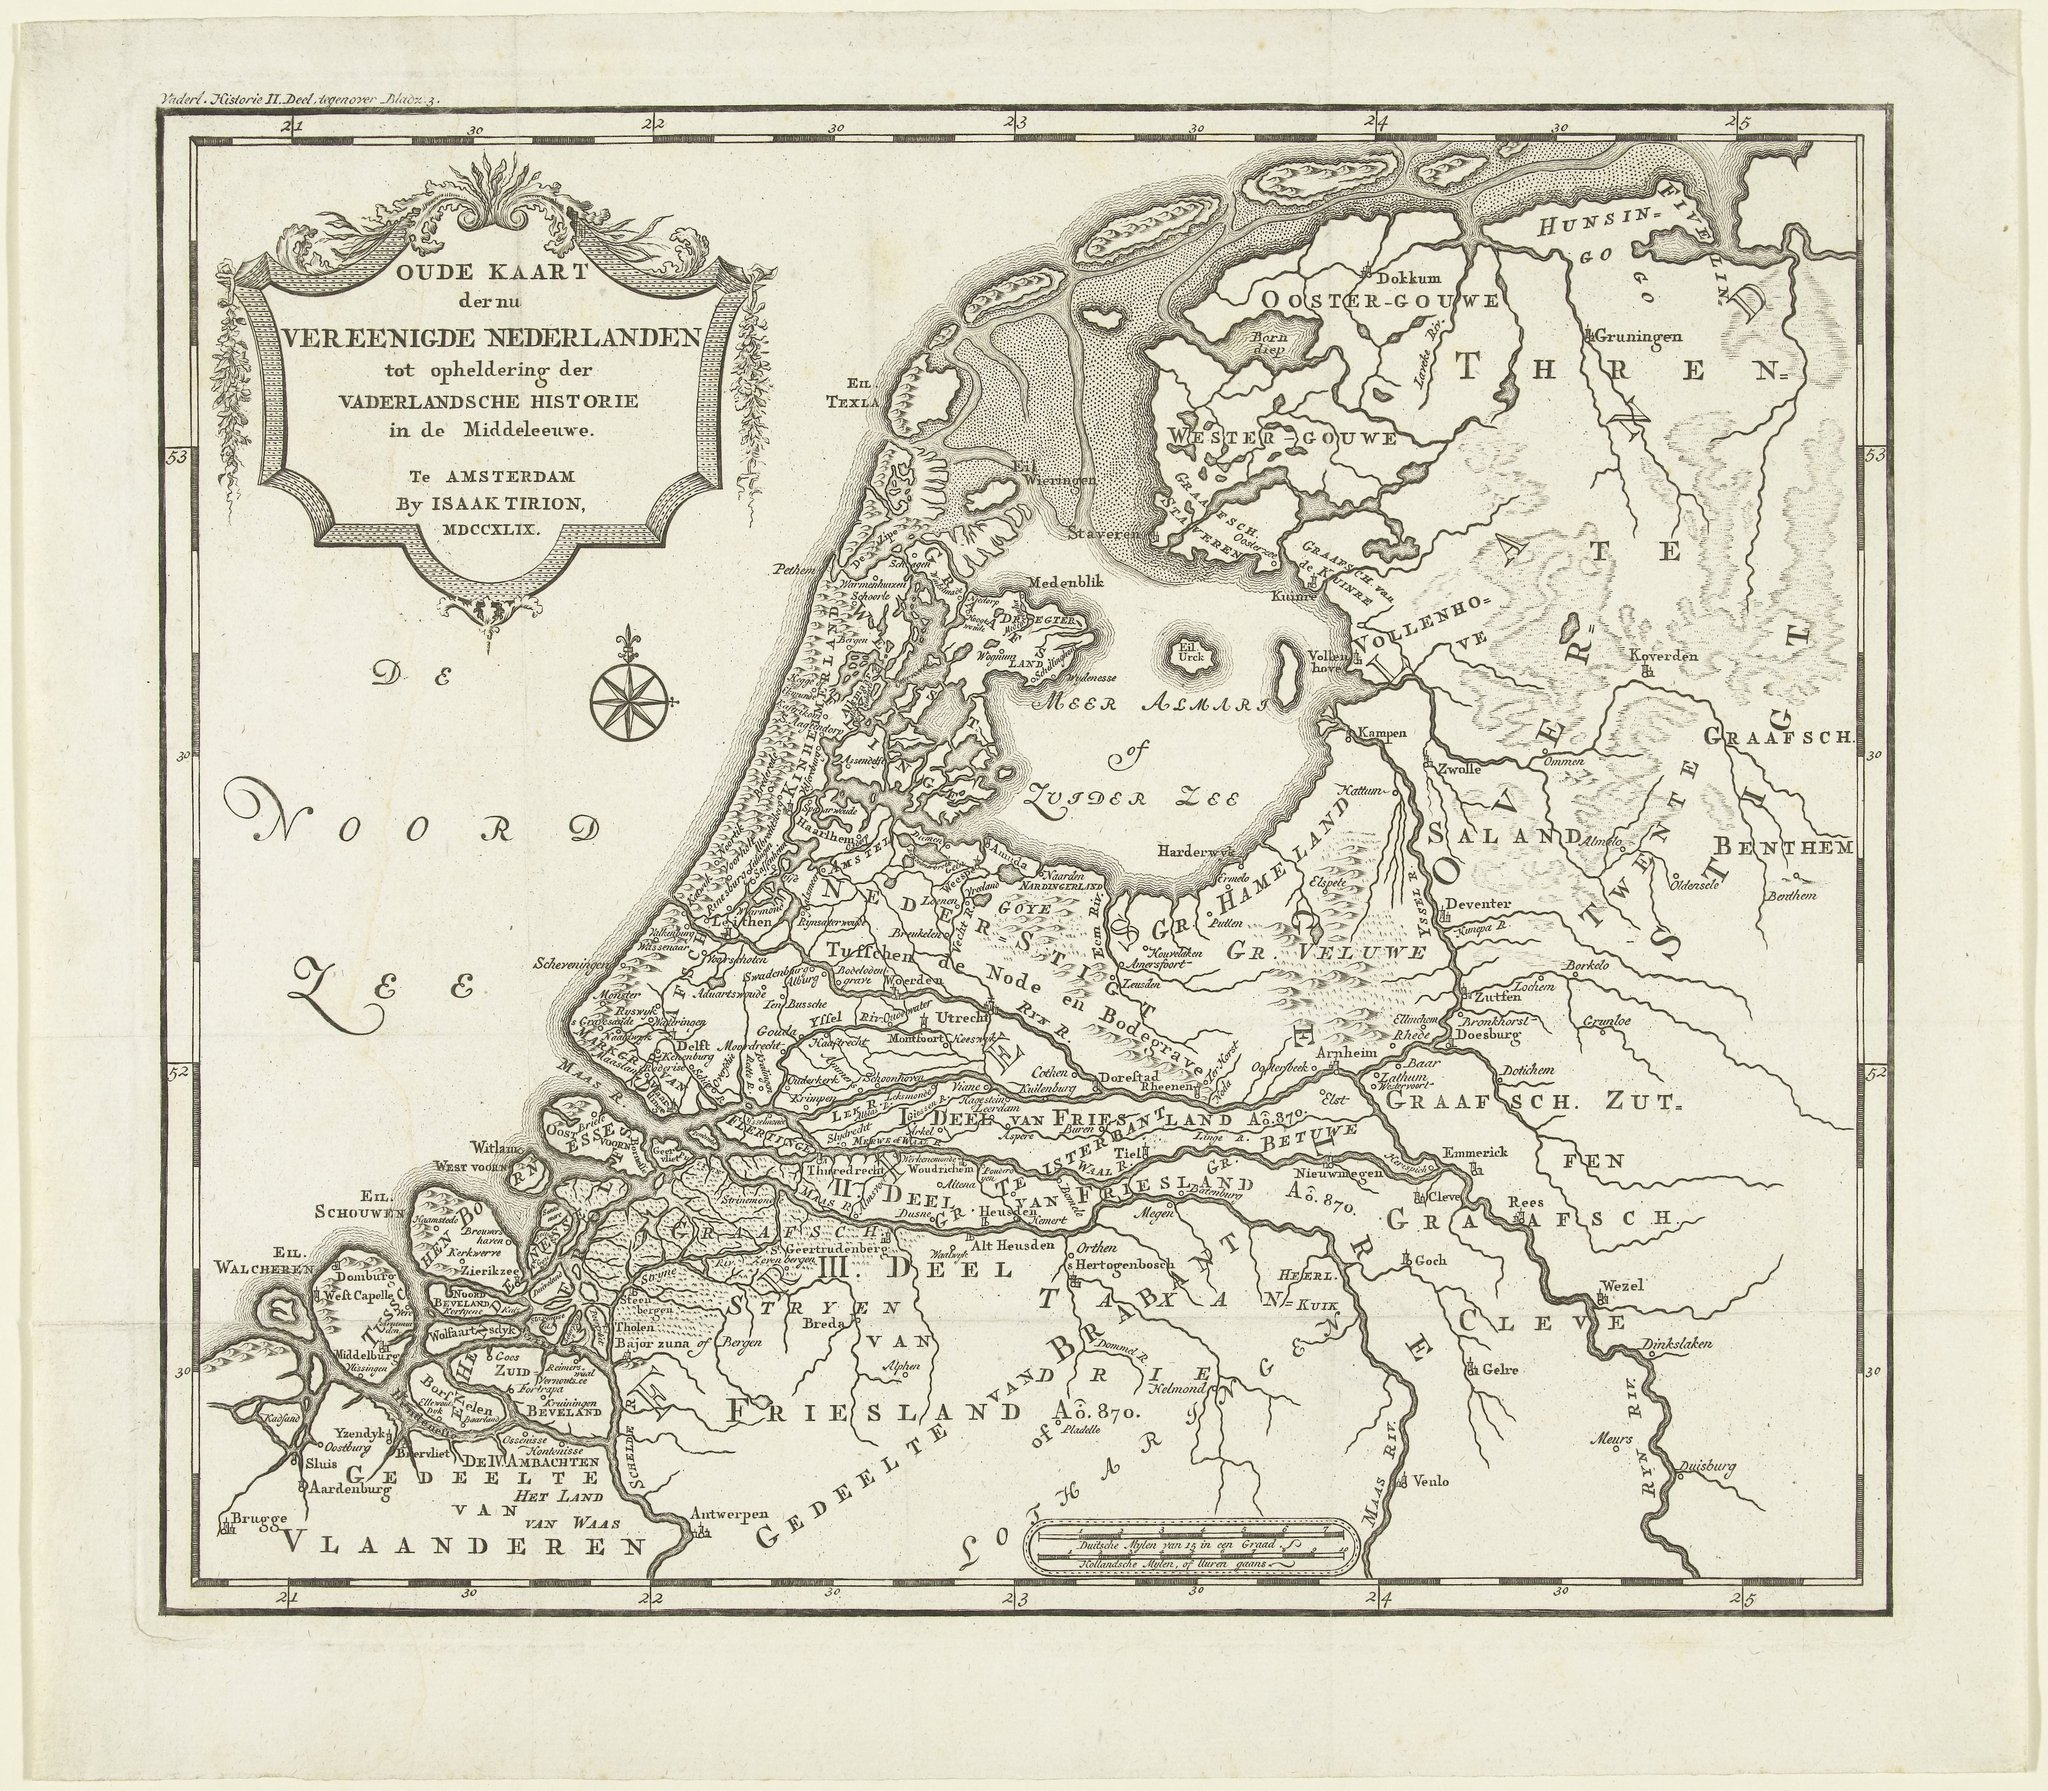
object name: history print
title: Oude Kaart der nu Vereenigde Nederlanden to opheldering der Vaderlandsche Historie in de Middeleeuwe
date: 1749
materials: paper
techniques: engraving, etching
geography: northern netherlands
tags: maps of separate countries or regions, netherlands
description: Illustratie voor: Jan Wagenaar, Vaderlandsche historie, Amsterdam 1749-1759, 21 delen, deel II, tegenover blz. 3.